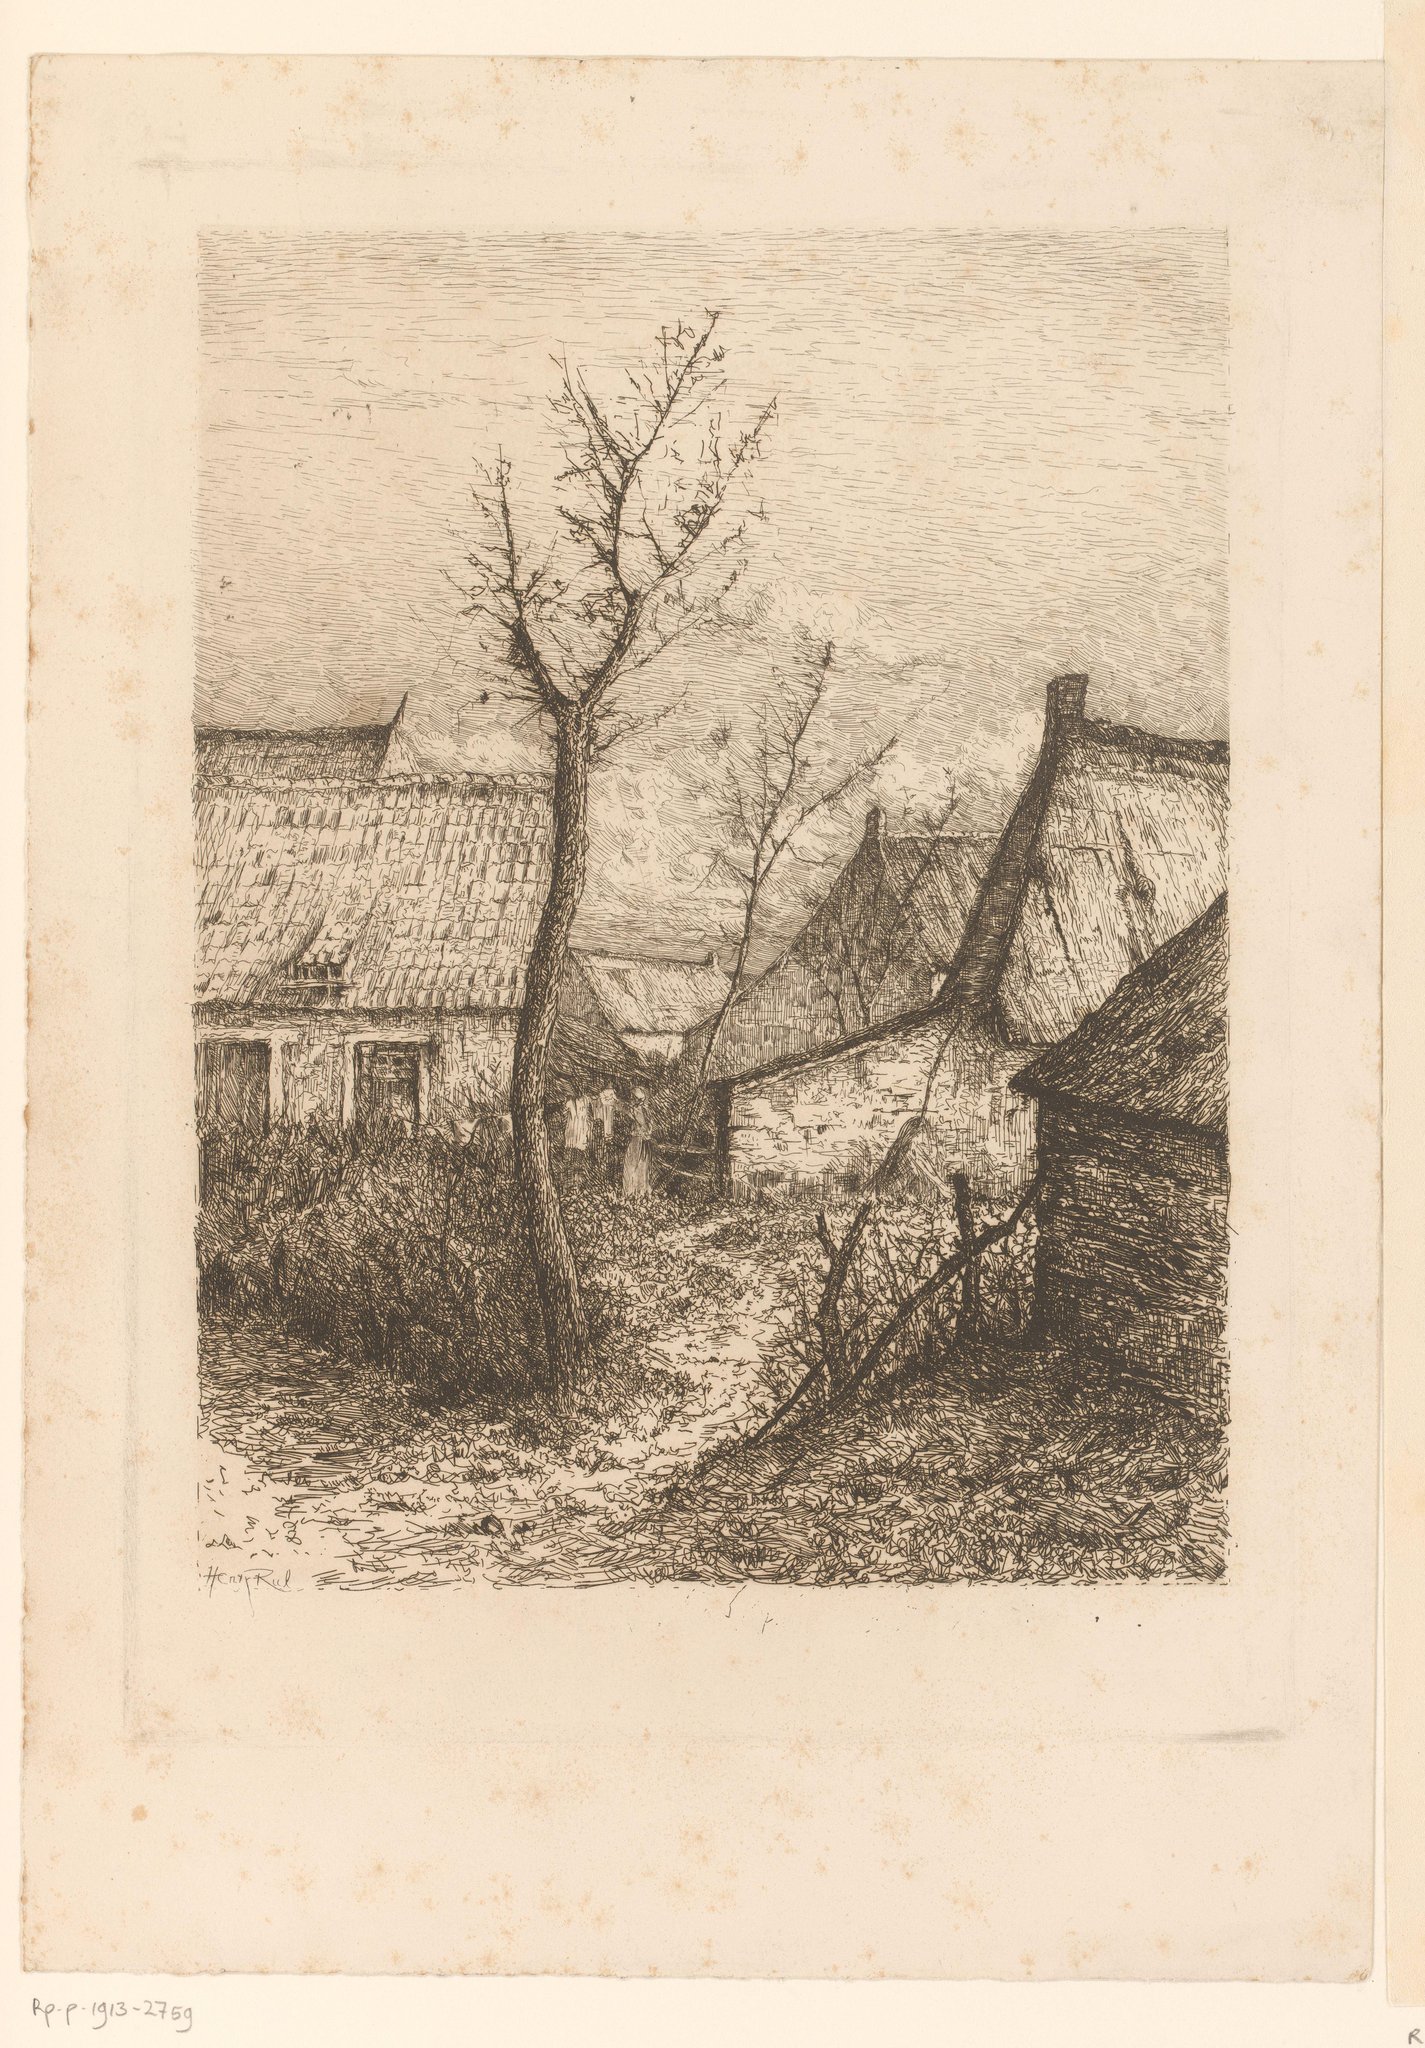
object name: print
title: Vrouw hangt buiten de was op bij een boerderij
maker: henri rul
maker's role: print maker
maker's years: 1862-1942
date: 1872-1913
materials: paper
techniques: etching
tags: adult woman, hanging the wash to dry, farm (building)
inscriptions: collector's mark: Lugt 2228